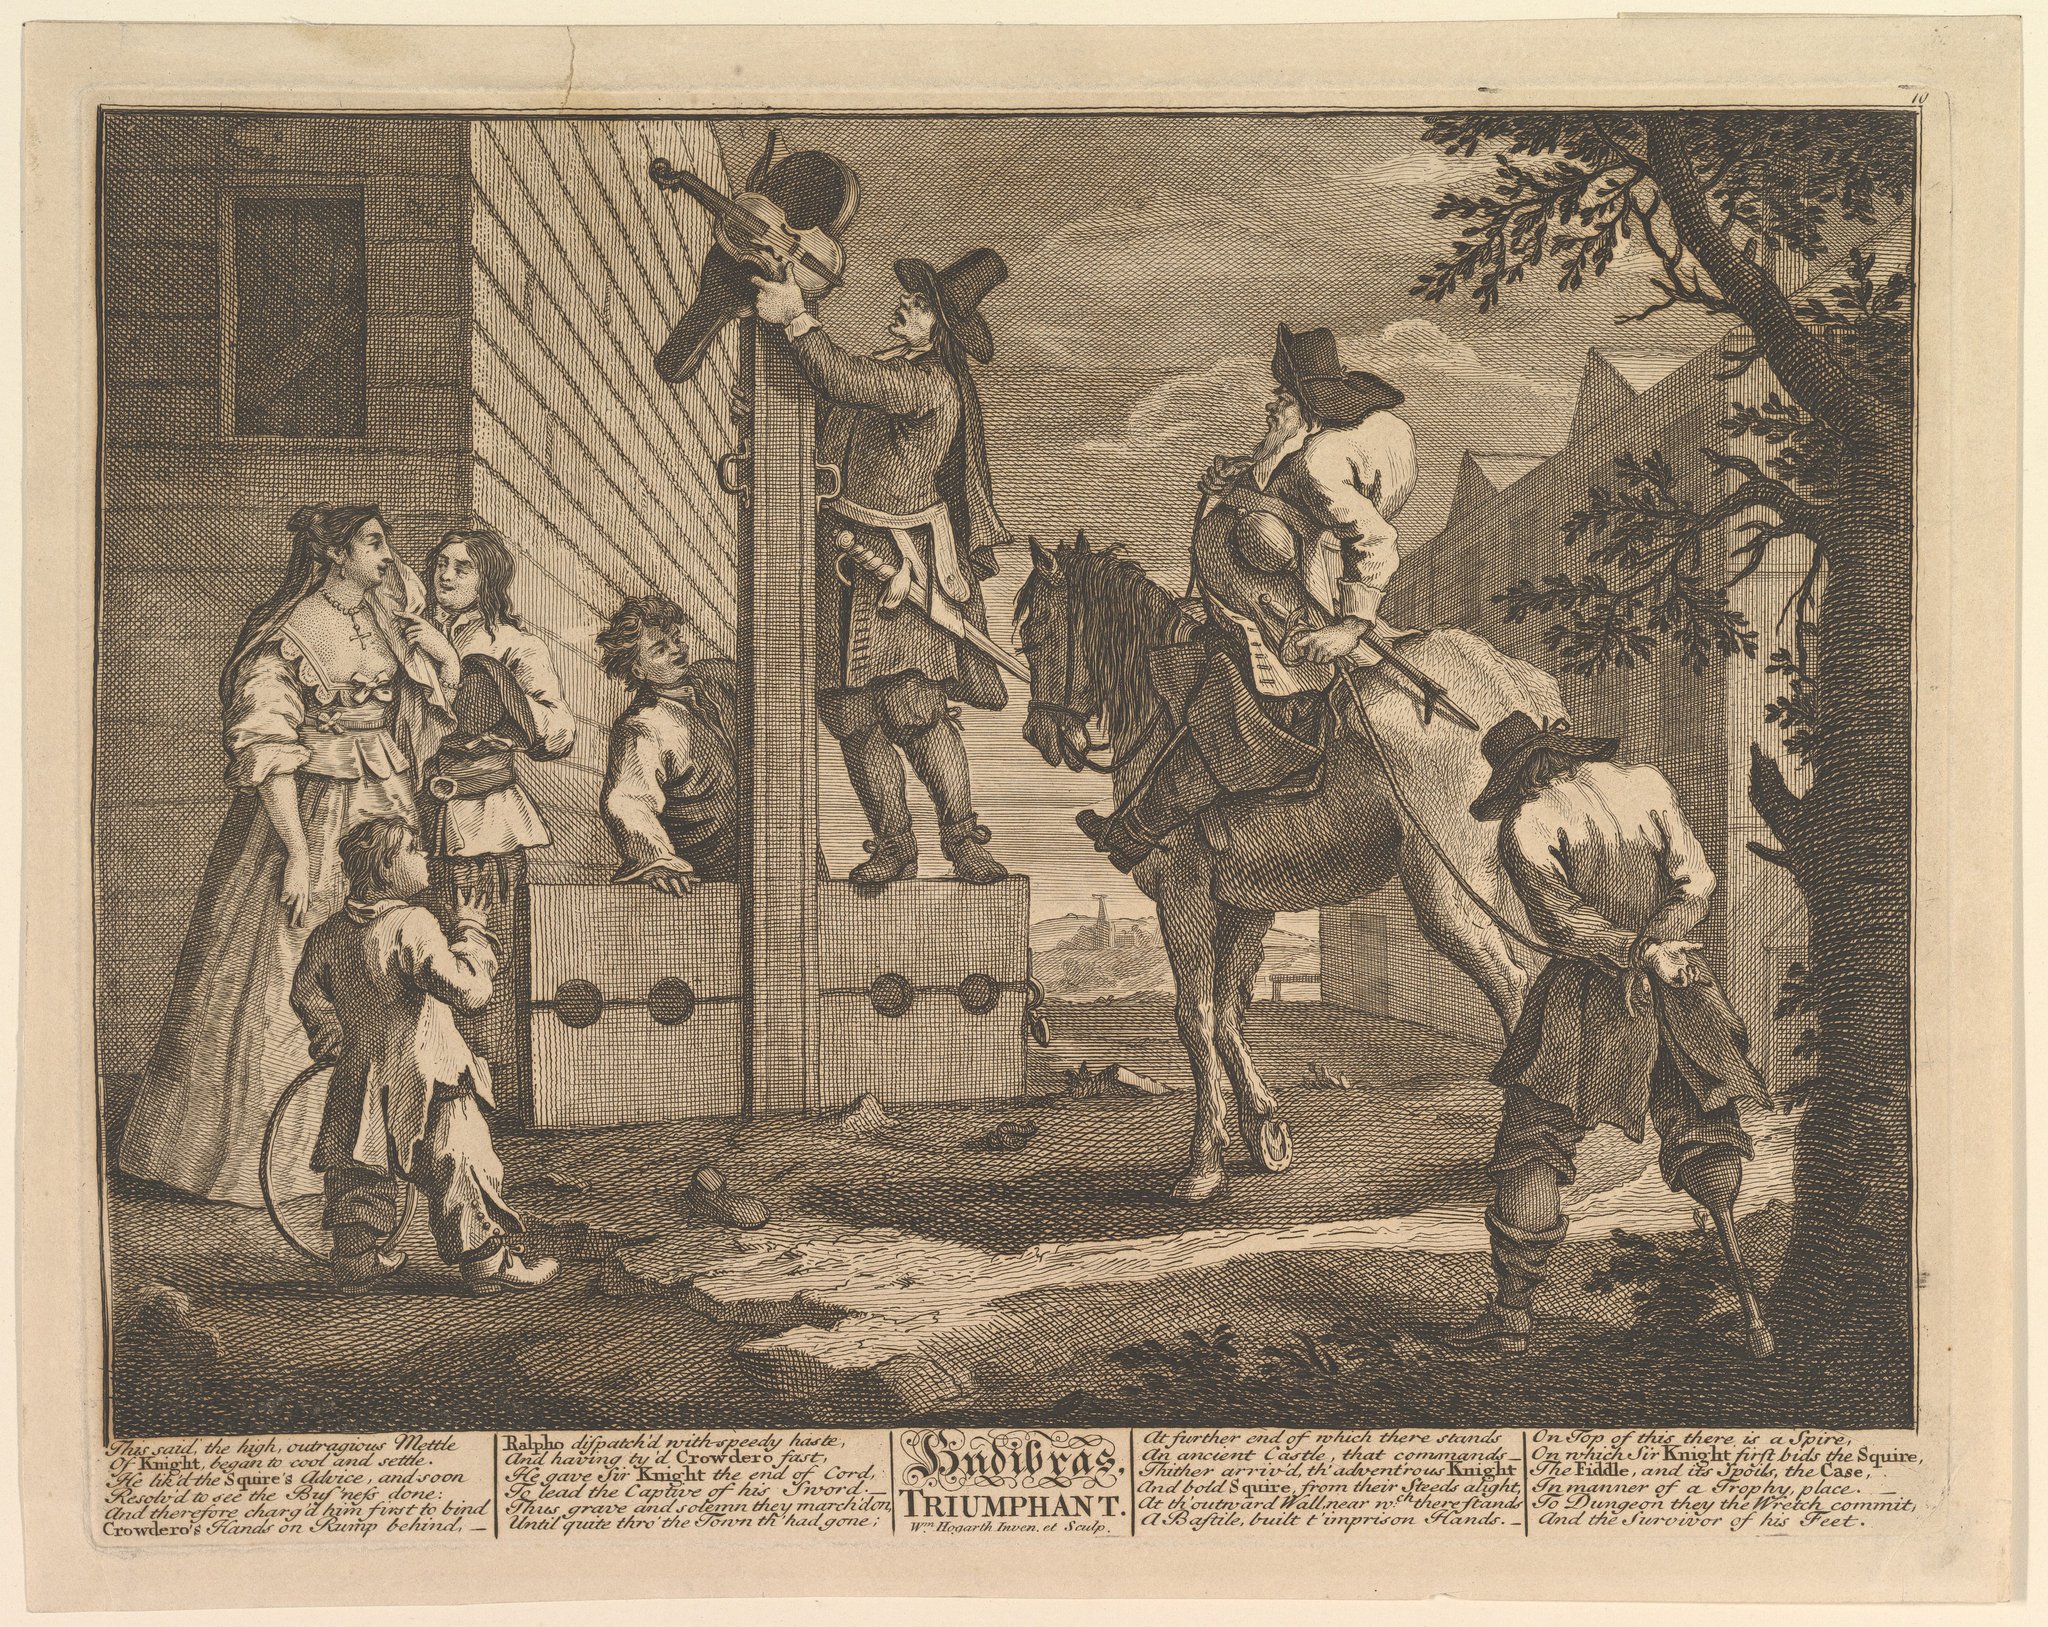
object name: print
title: Hudibras Triumphant (Twelve Large Illustrations for Samuel Butler's Hudibras, Plate 4)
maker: william hogarth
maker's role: artist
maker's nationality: british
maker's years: 1697-1764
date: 1725-1768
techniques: engraving, etching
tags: men,women,violins,horses